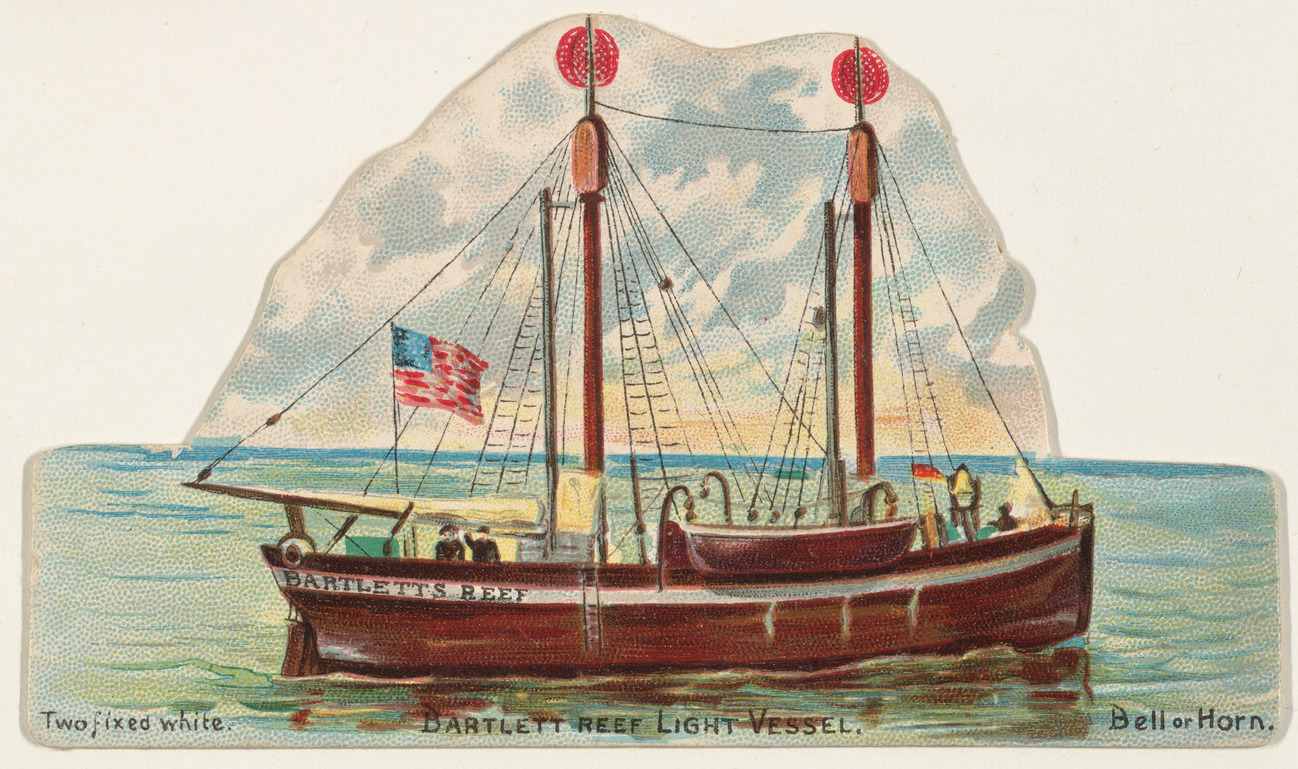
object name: print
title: Bartlett Reef Light Vessel, from the Lighthouses series (N119) issued by Duke Sons & Co. to promote Honest Long Cut Tobacco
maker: w. duke, sons & co.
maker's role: publisher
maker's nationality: american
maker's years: 1870-1920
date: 1889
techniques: color lithograph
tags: boats